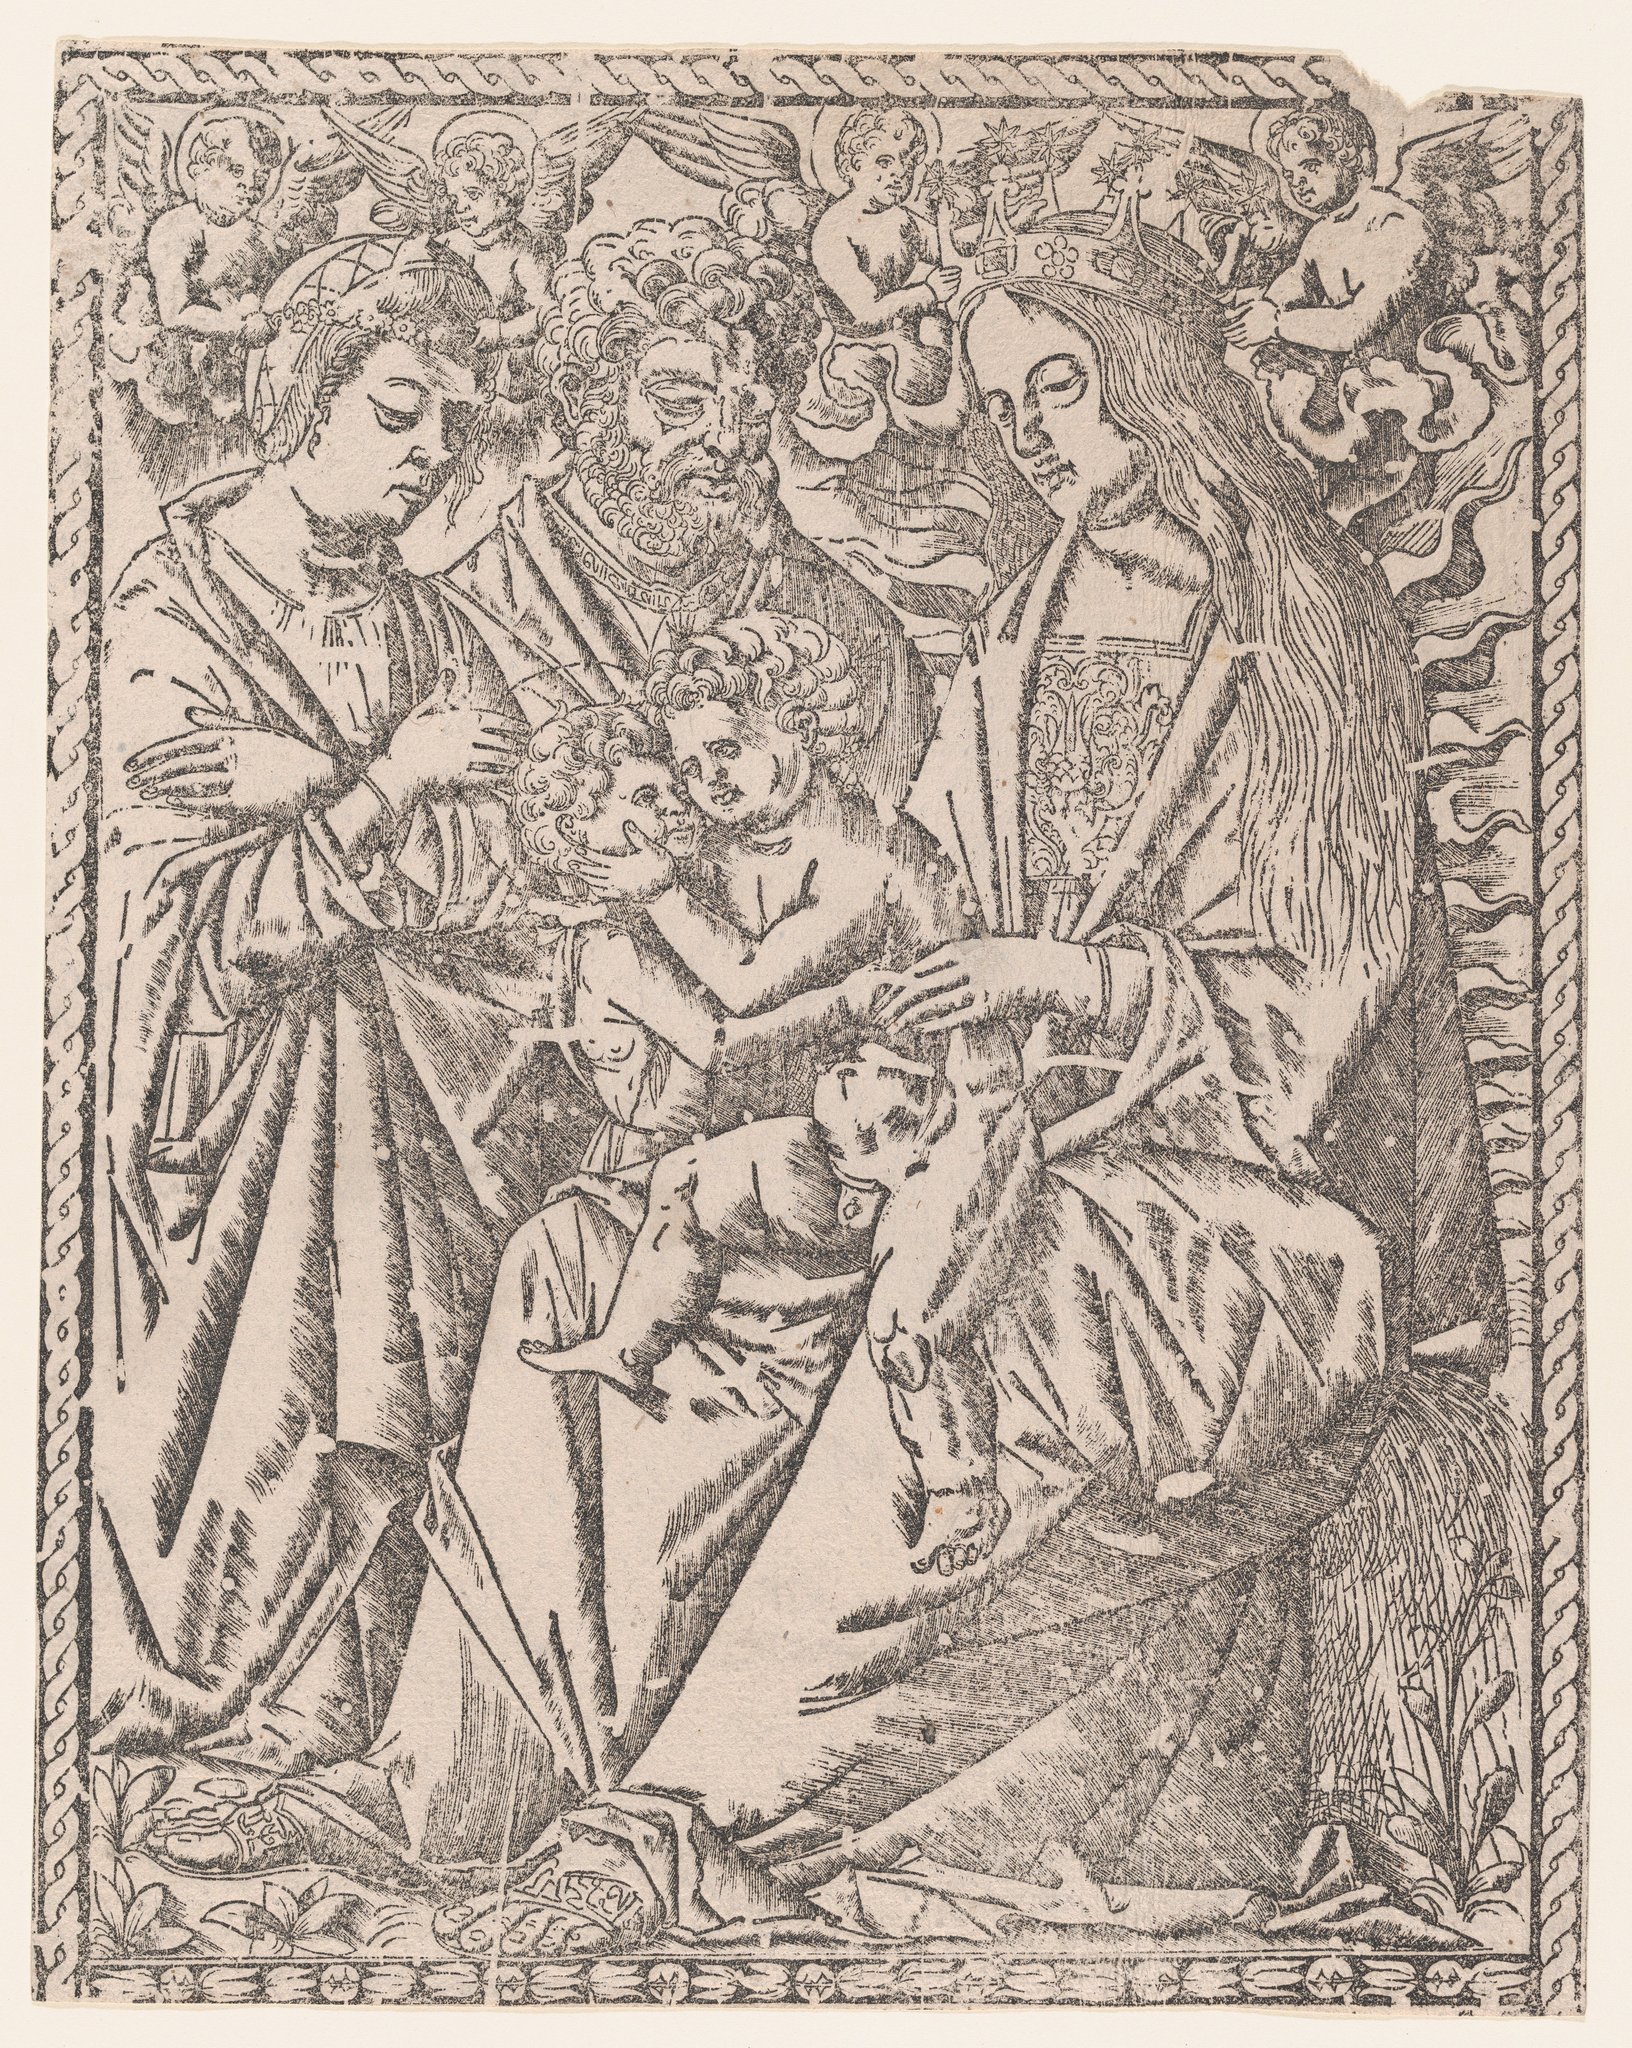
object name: print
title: Saint John the Baptist embracing the Christ Child who sits on the Virgin's knee, she is being crowned by angels, other saints at left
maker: anonymous, italian, 16th century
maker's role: artist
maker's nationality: italian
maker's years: 1500-1600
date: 1500-1550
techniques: woodcut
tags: angels,madonna and child,saint john the baptist,saints